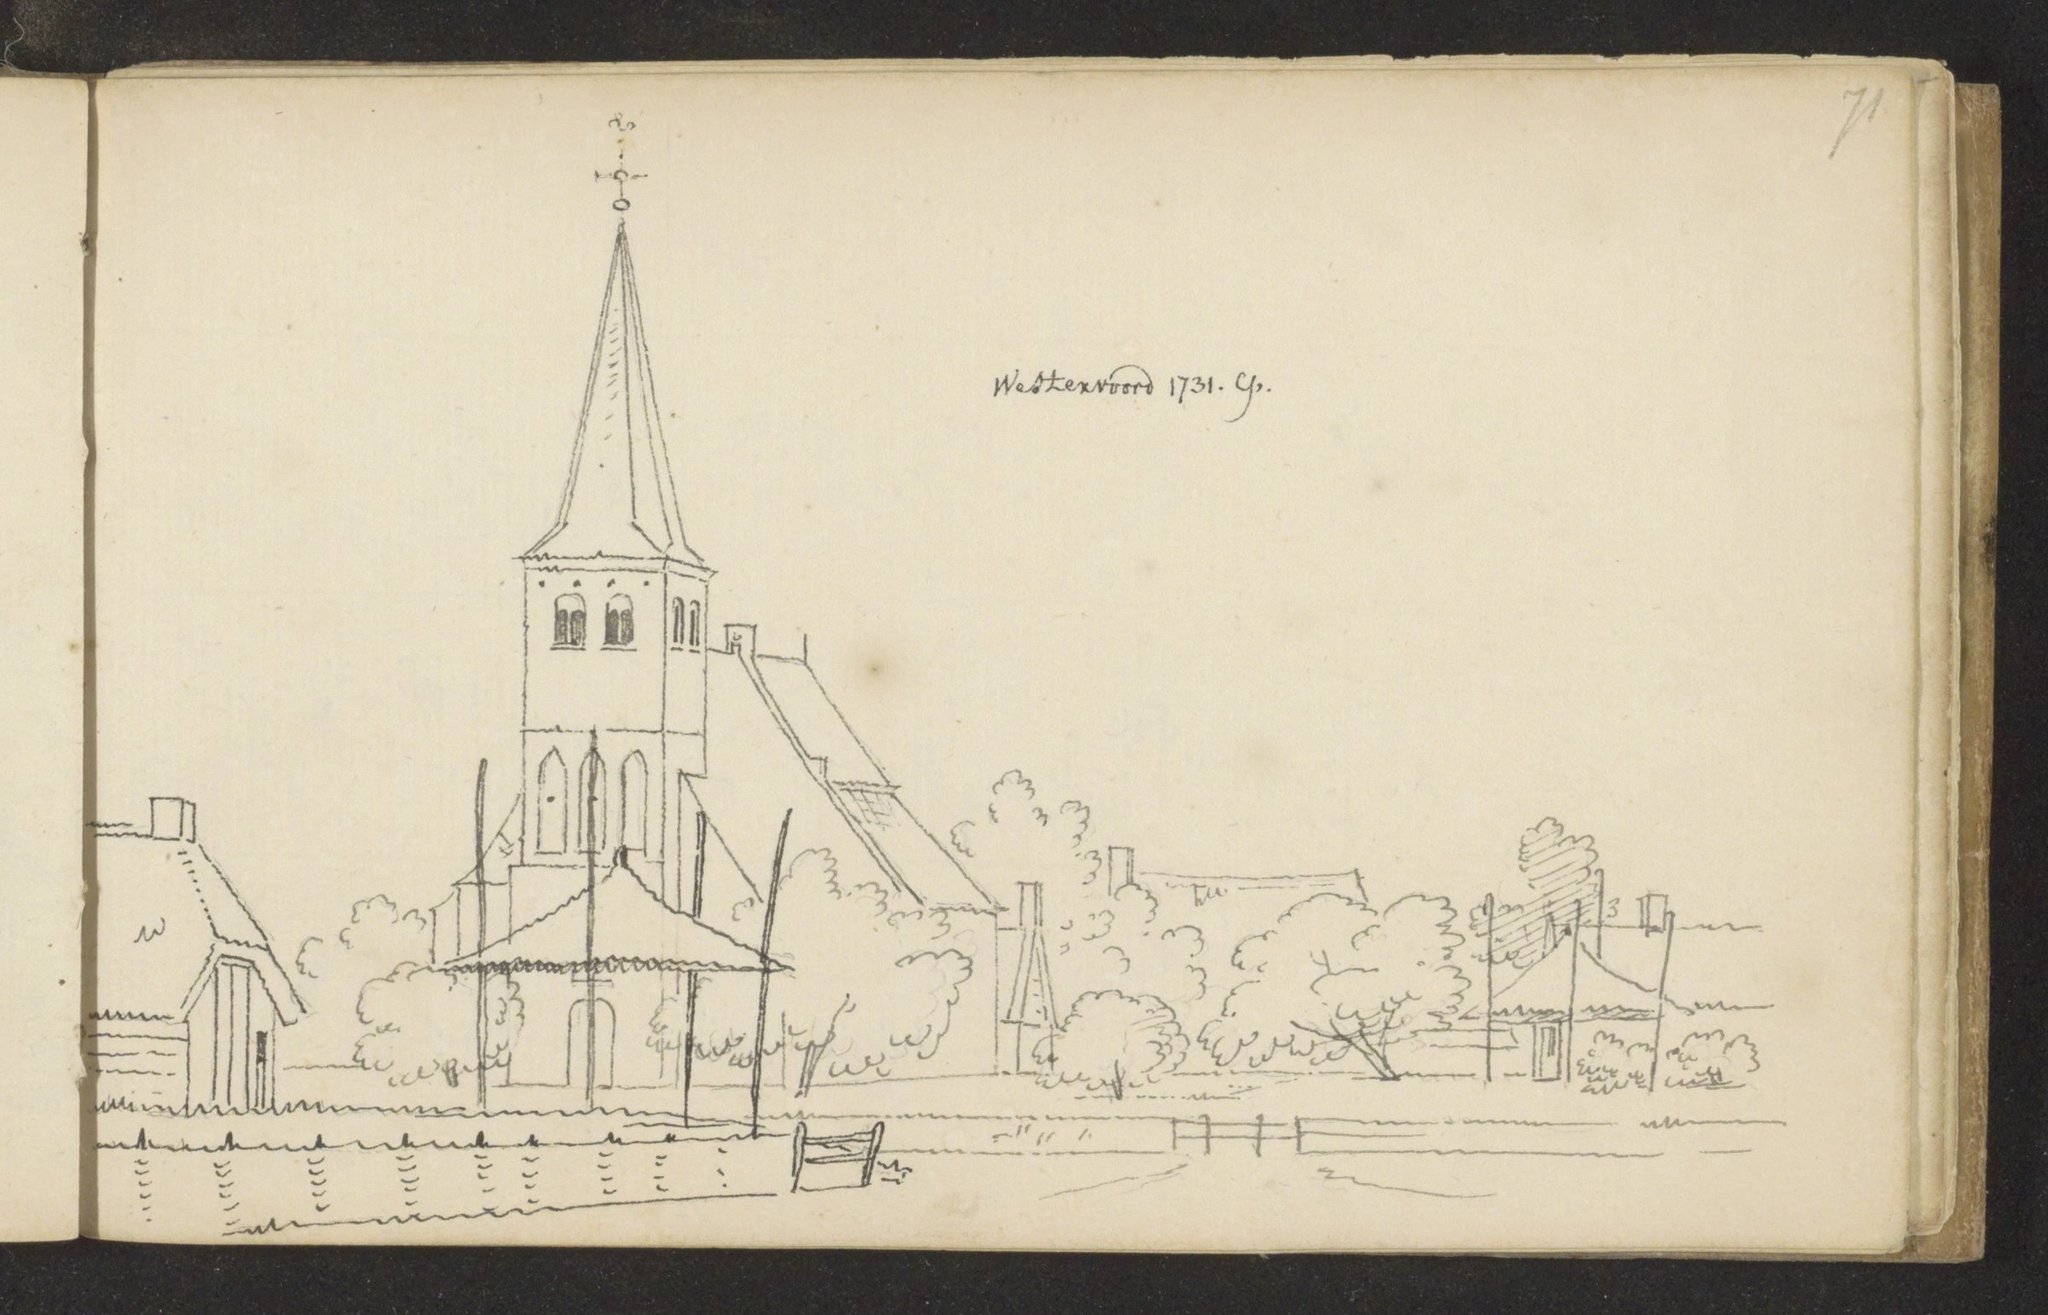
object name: sketchbook leaf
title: Dorpsgezicht te Westervoort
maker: abraham de haen (ii)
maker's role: draughtsman, print maker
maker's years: 1707-1748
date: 1731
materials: ink, paper, pencil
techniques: pen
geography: westervoort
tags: village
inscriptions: date and inscription: ‘Westervoort 1731. cp.’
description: Blad 71 recto uit een schetsboek met 78 bladen.